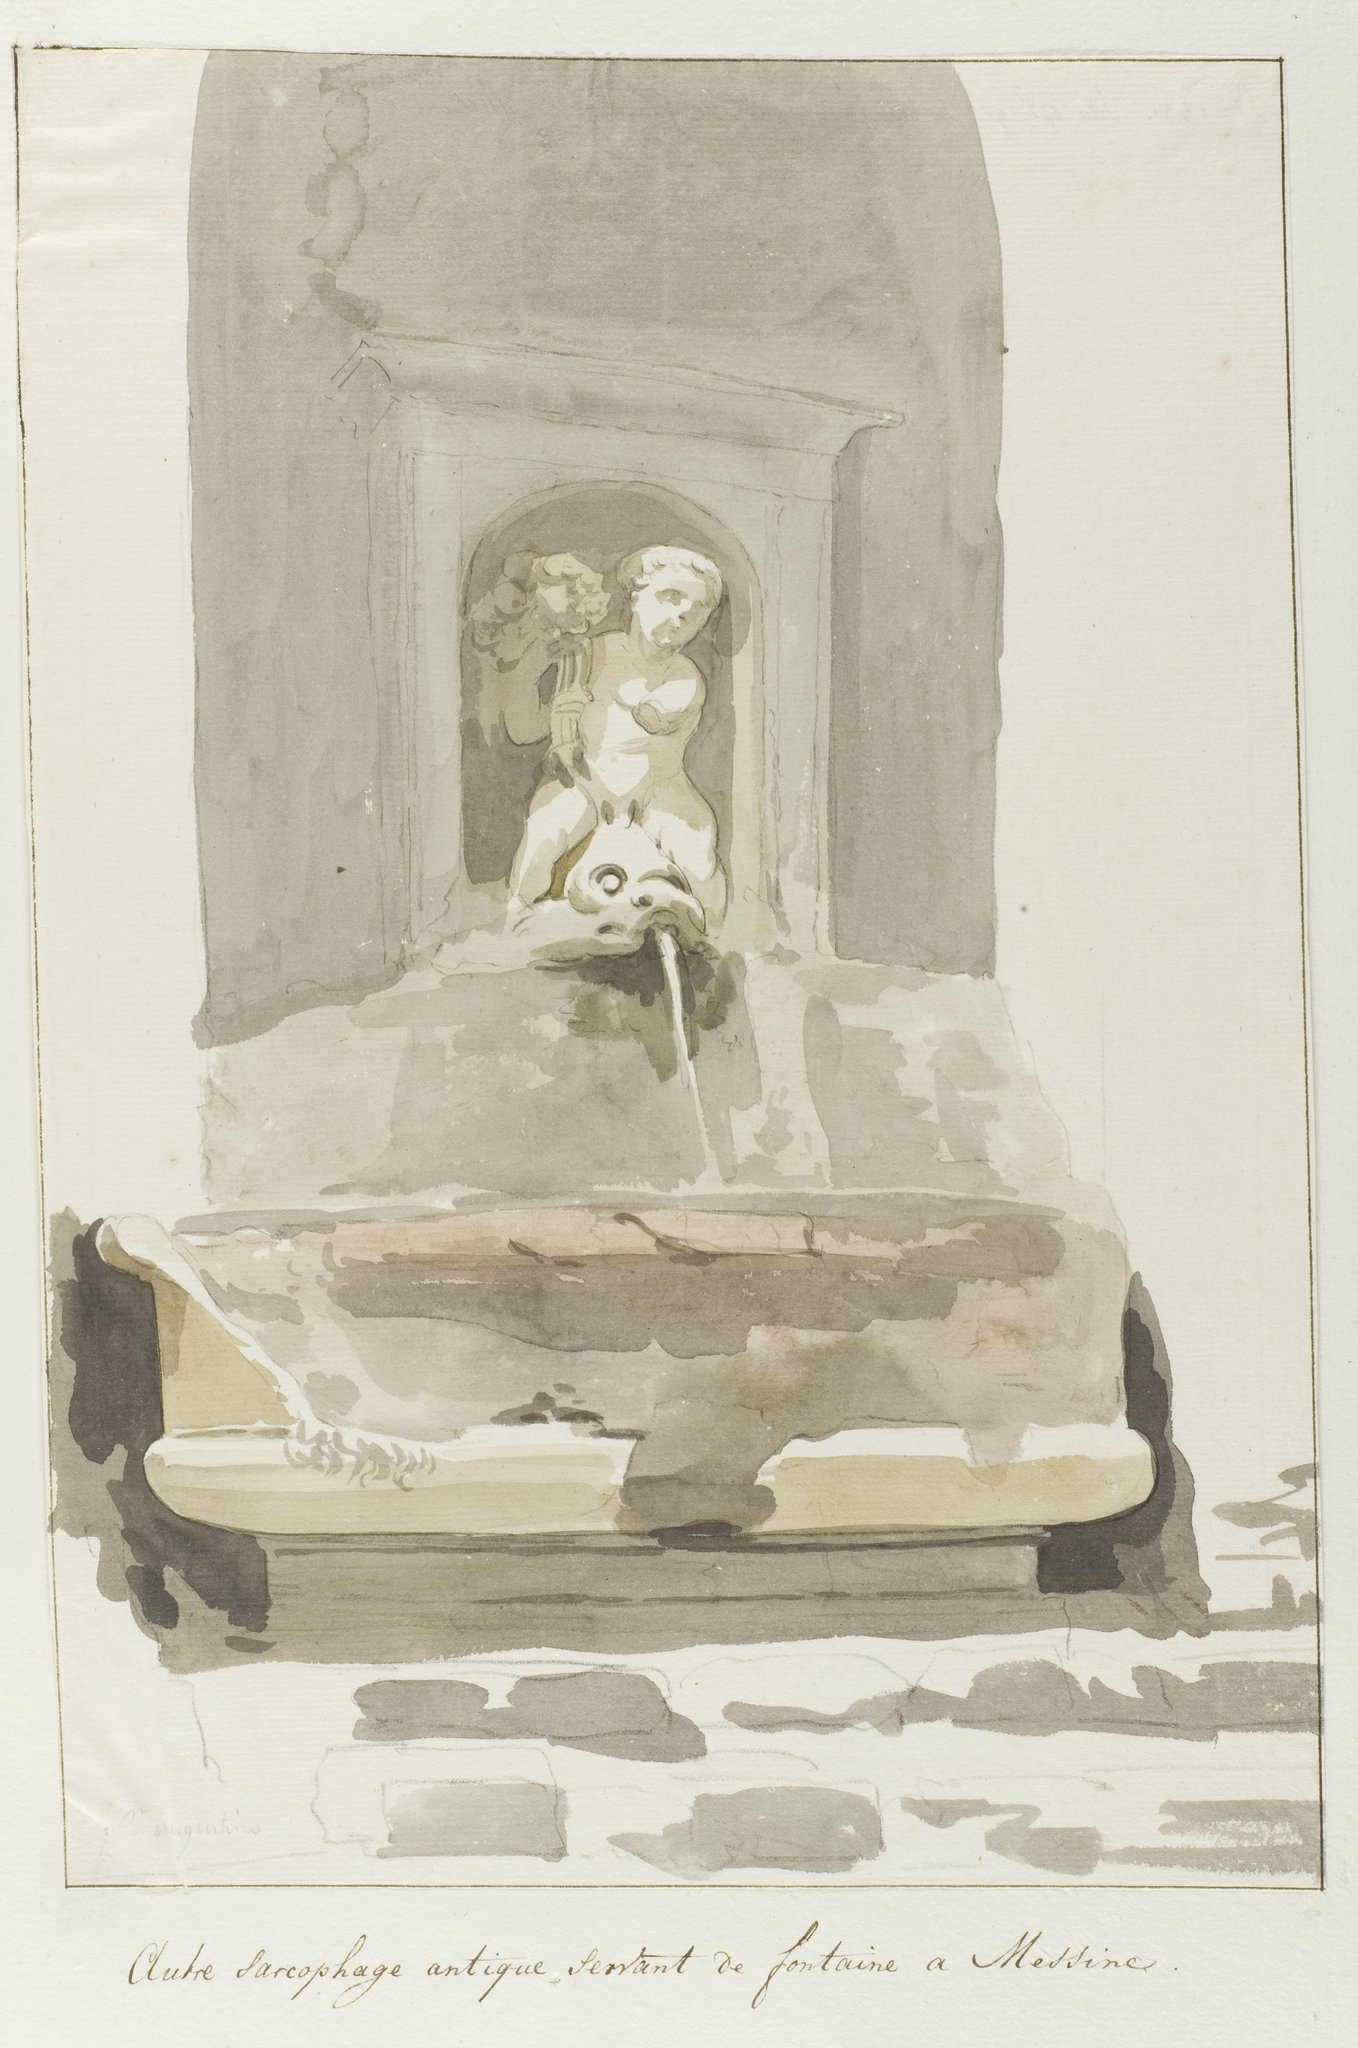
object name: watercolor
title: Sarcophage antique servant de fontaine à Messine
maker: louis ducros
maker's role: draughtsman, print maker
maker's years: 1748-1810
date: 1778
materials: chalk, paper, watercolor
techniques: brush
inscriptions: inscription: ‘No 133 Sarcophage antique servant de fontaine à Messine’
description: Tekening uit het album 'Voyage en Italie, en Sicile et à Malte', 1778.